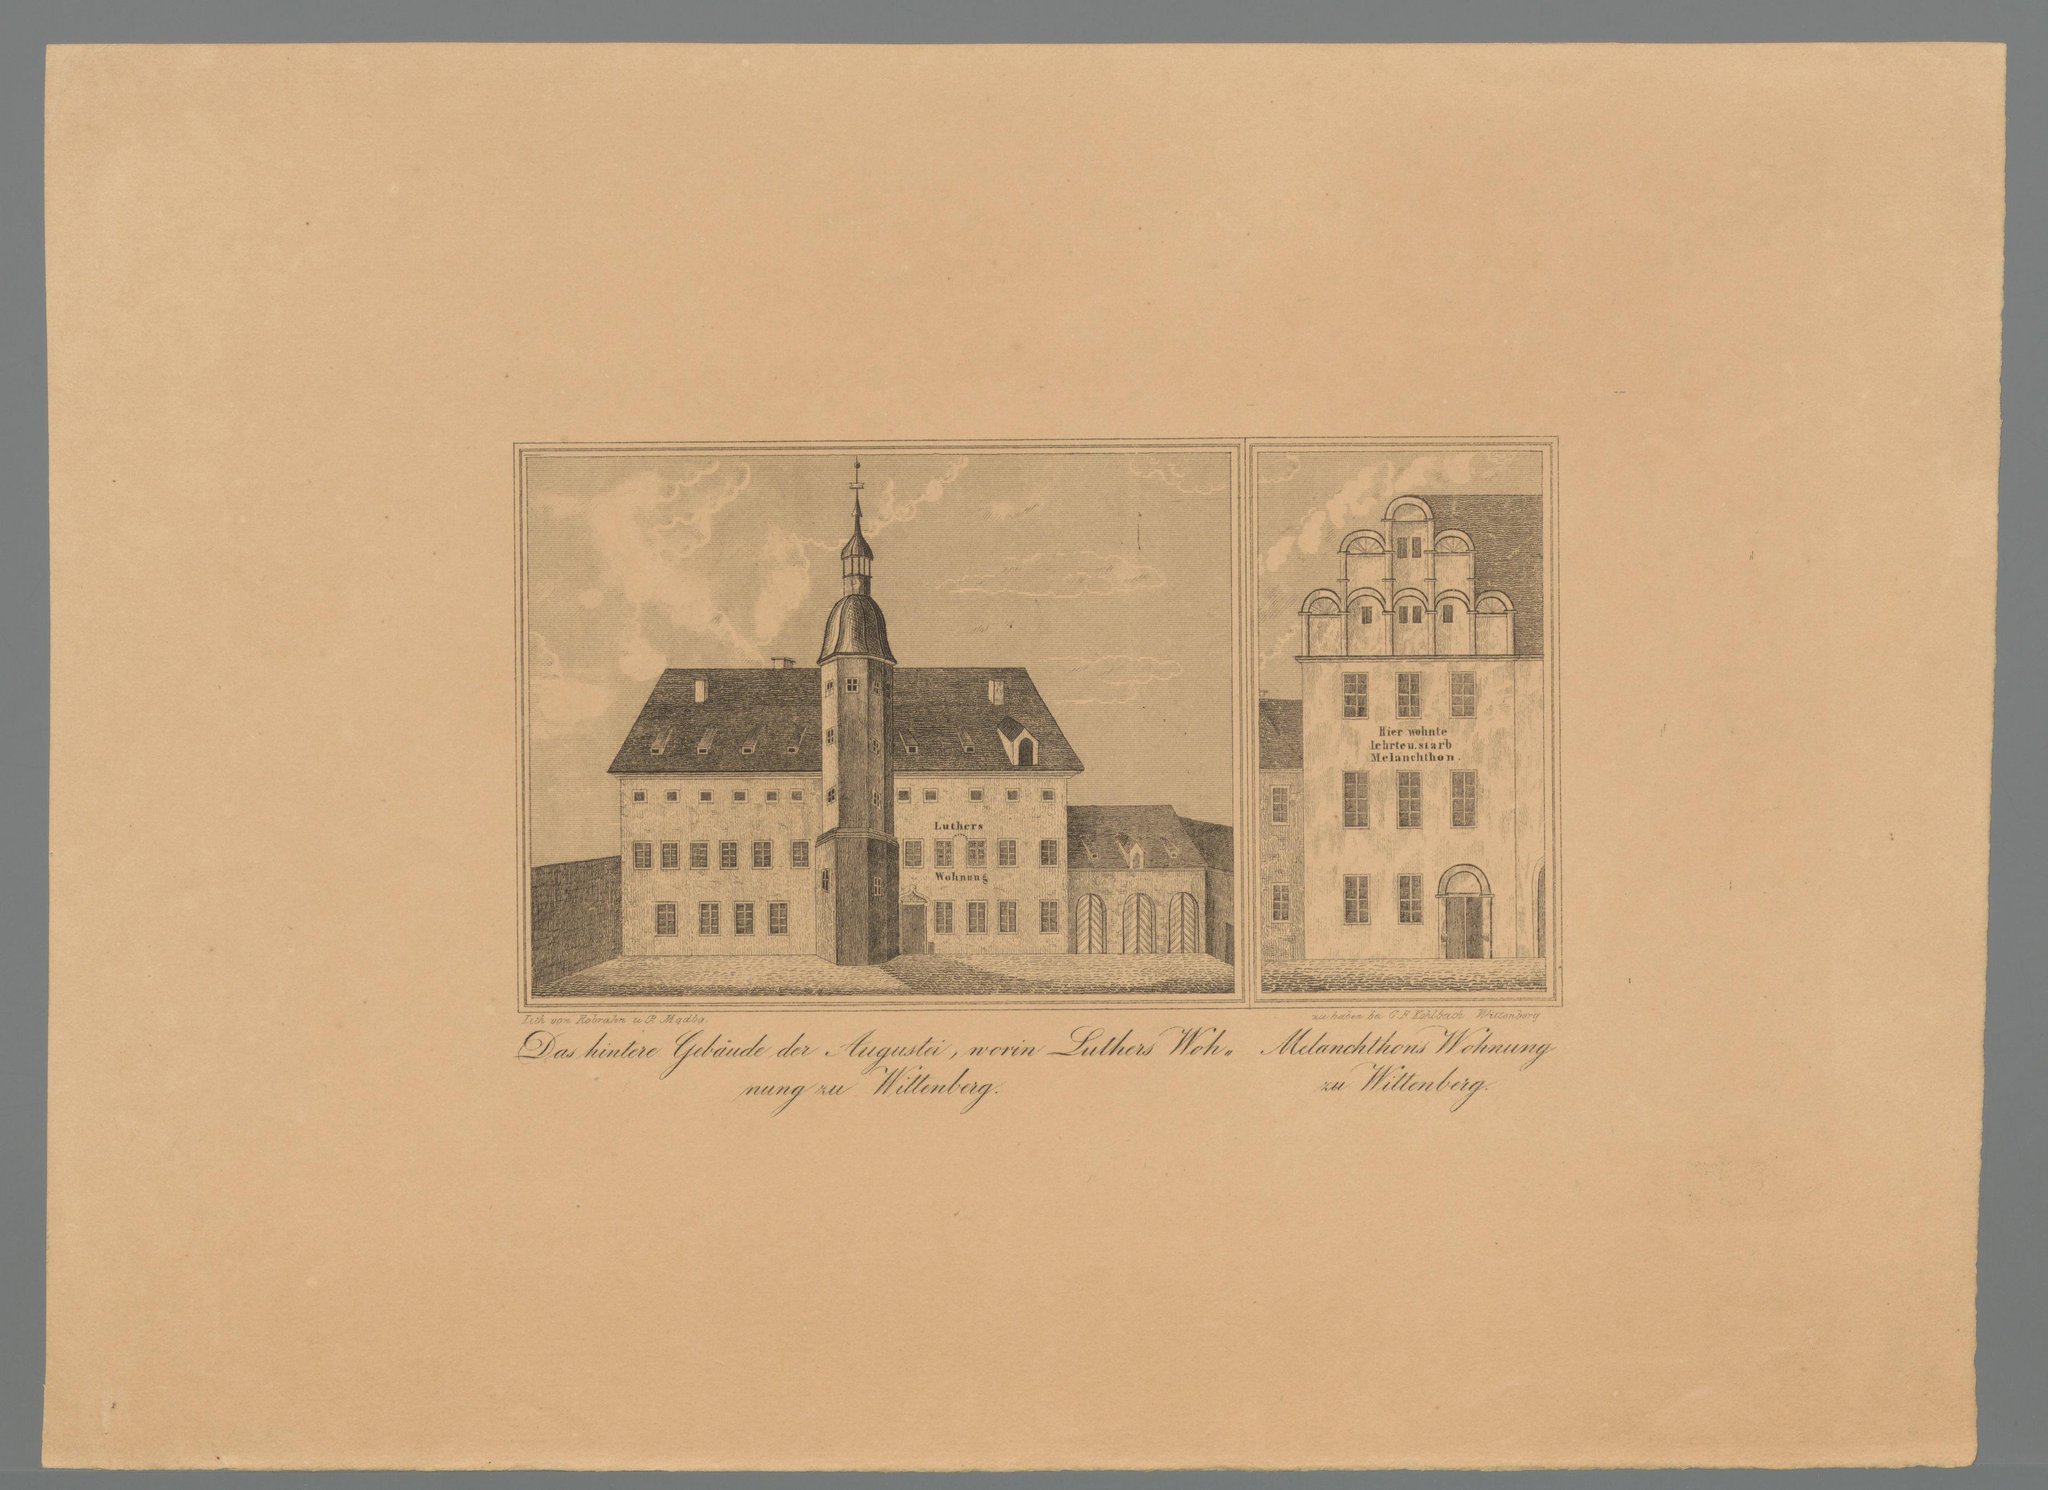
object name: print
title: Woningen van Luther en Melanchton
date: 1823-1880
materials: paper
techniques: lithograph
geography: magdeburg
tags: façade (of house or building)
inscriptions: collector's mark: Lugt 2228